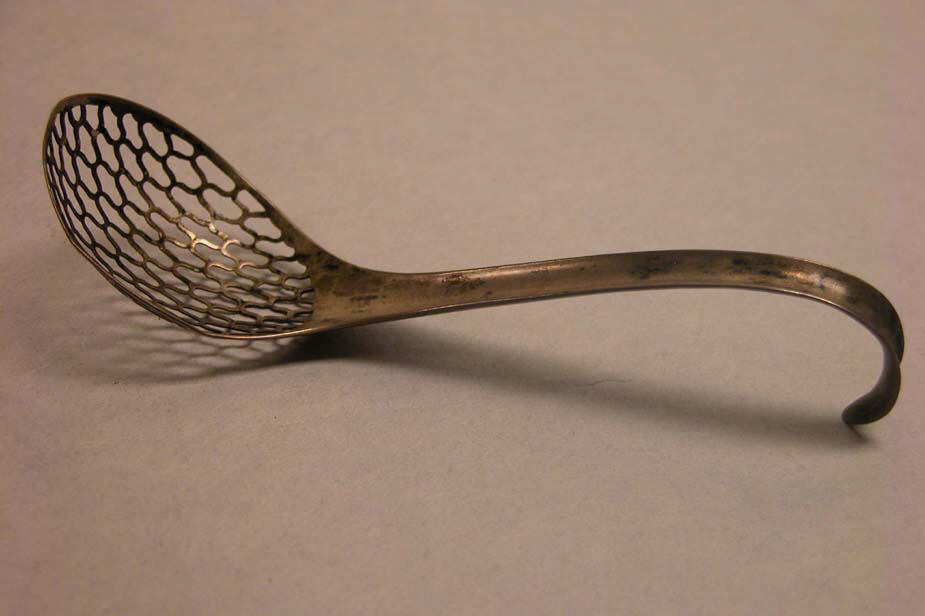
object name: sifter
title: Sugar Sifter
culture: japanese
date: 1801-1900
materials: silver